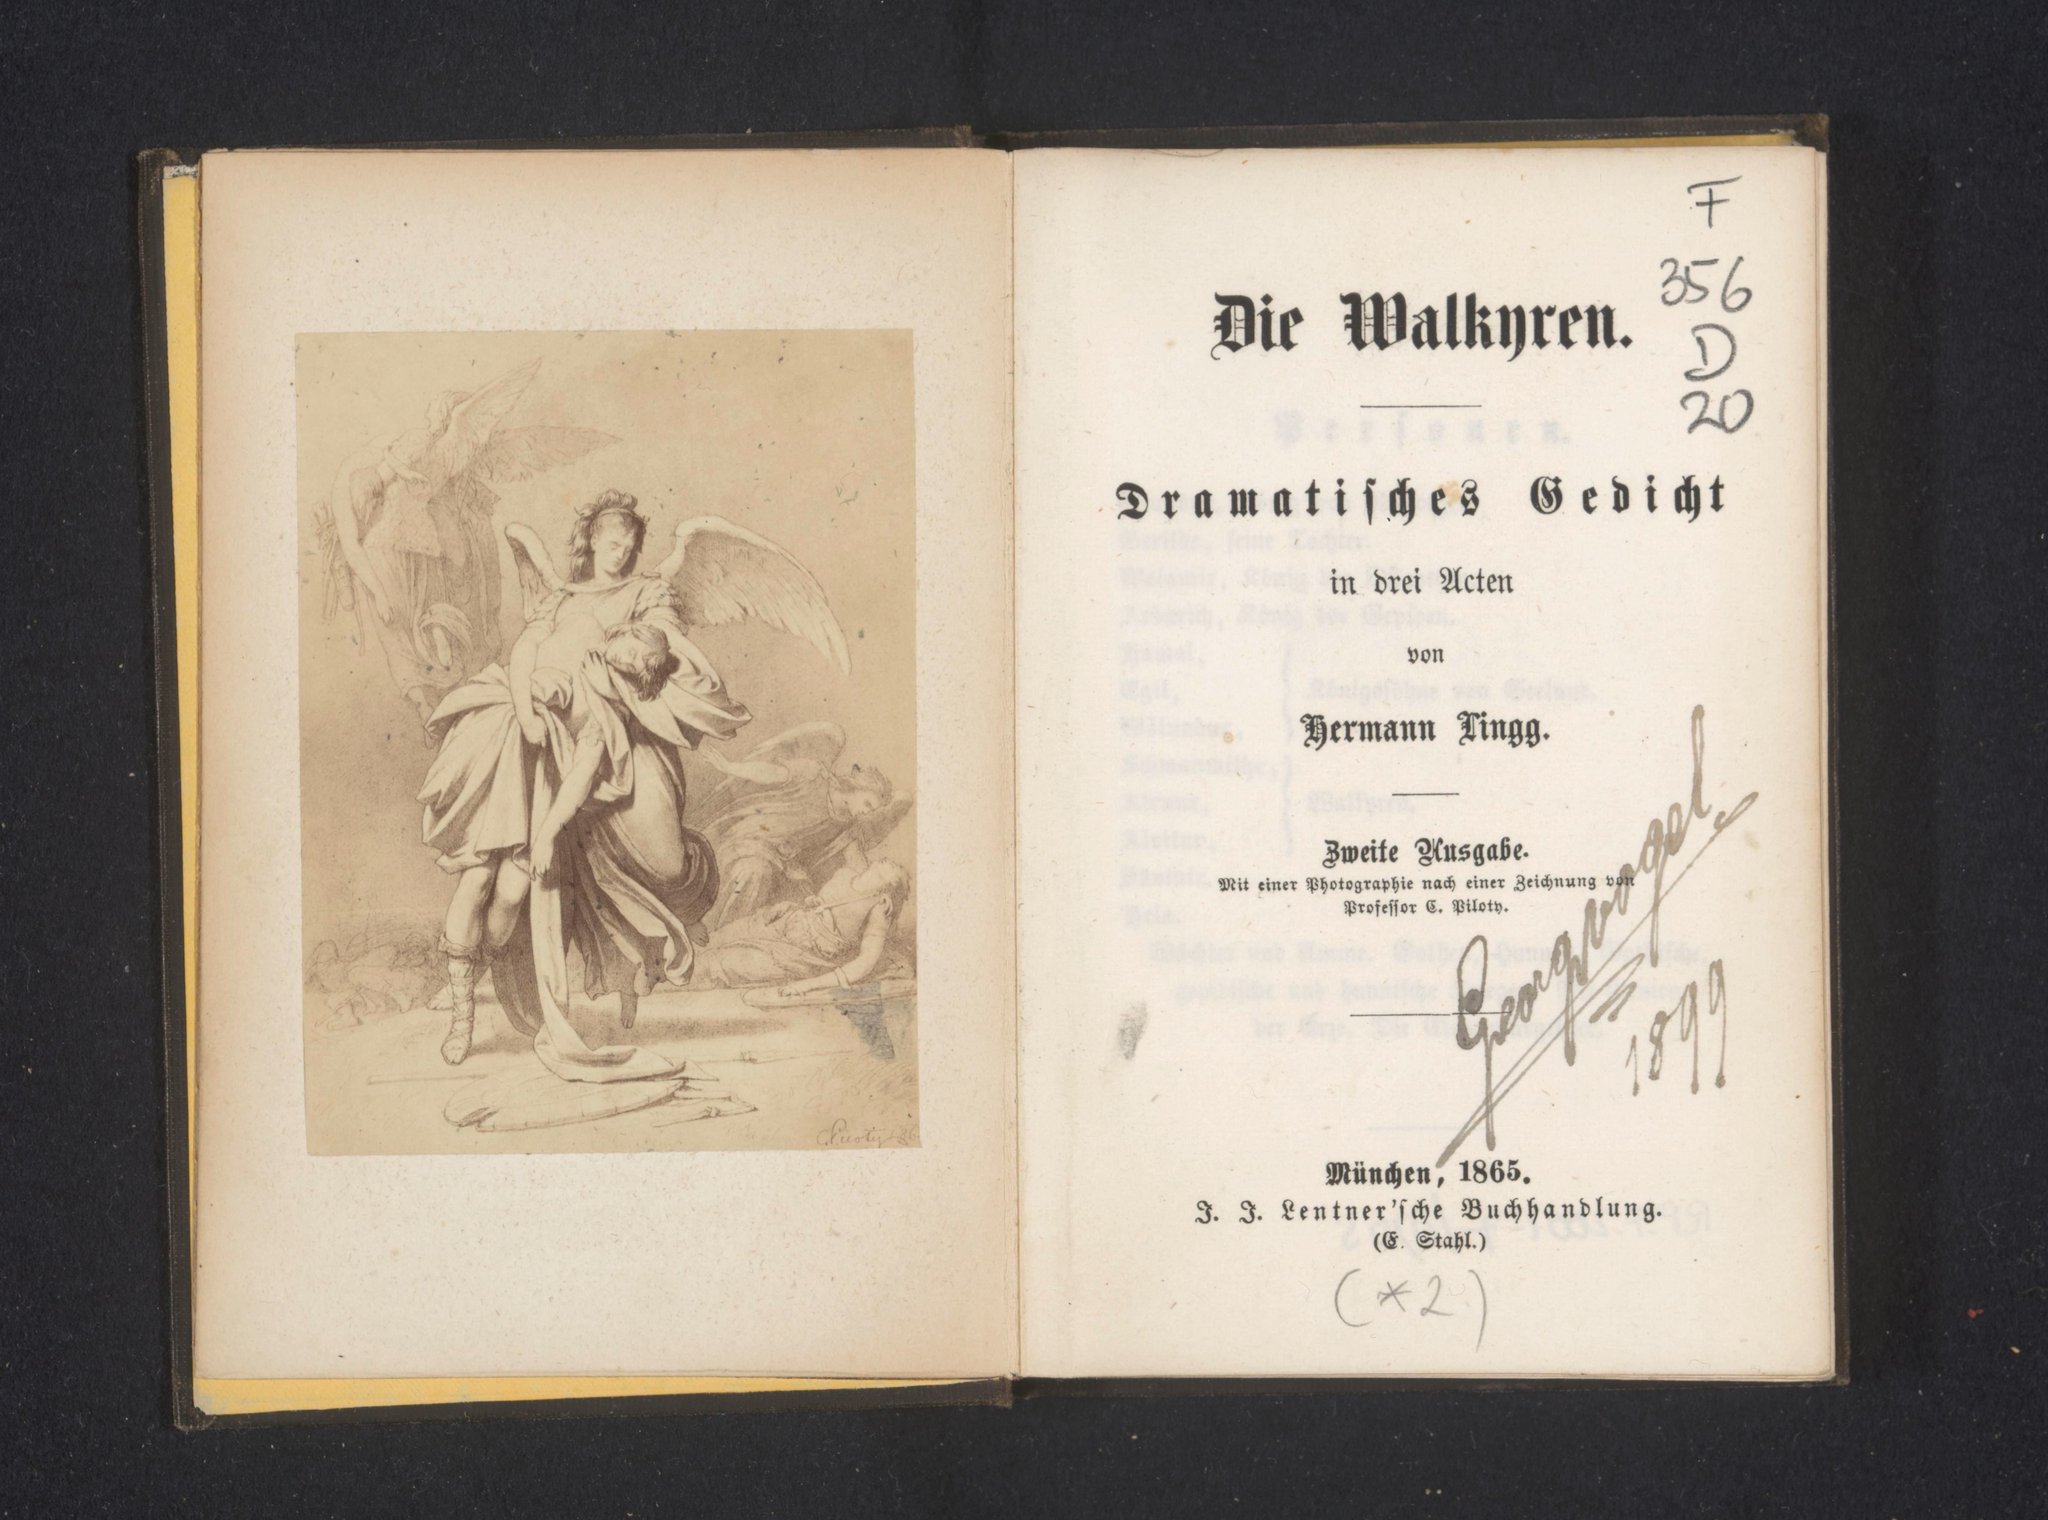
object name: reproduction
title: Fotoreproductie van een tekening, voorstellende Walkuren dragen gedode strijders van een slagveld weg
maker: Anonymous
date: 1860-1865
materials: photographic support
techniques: albumen print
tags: fabulous beings with wings, the corpse